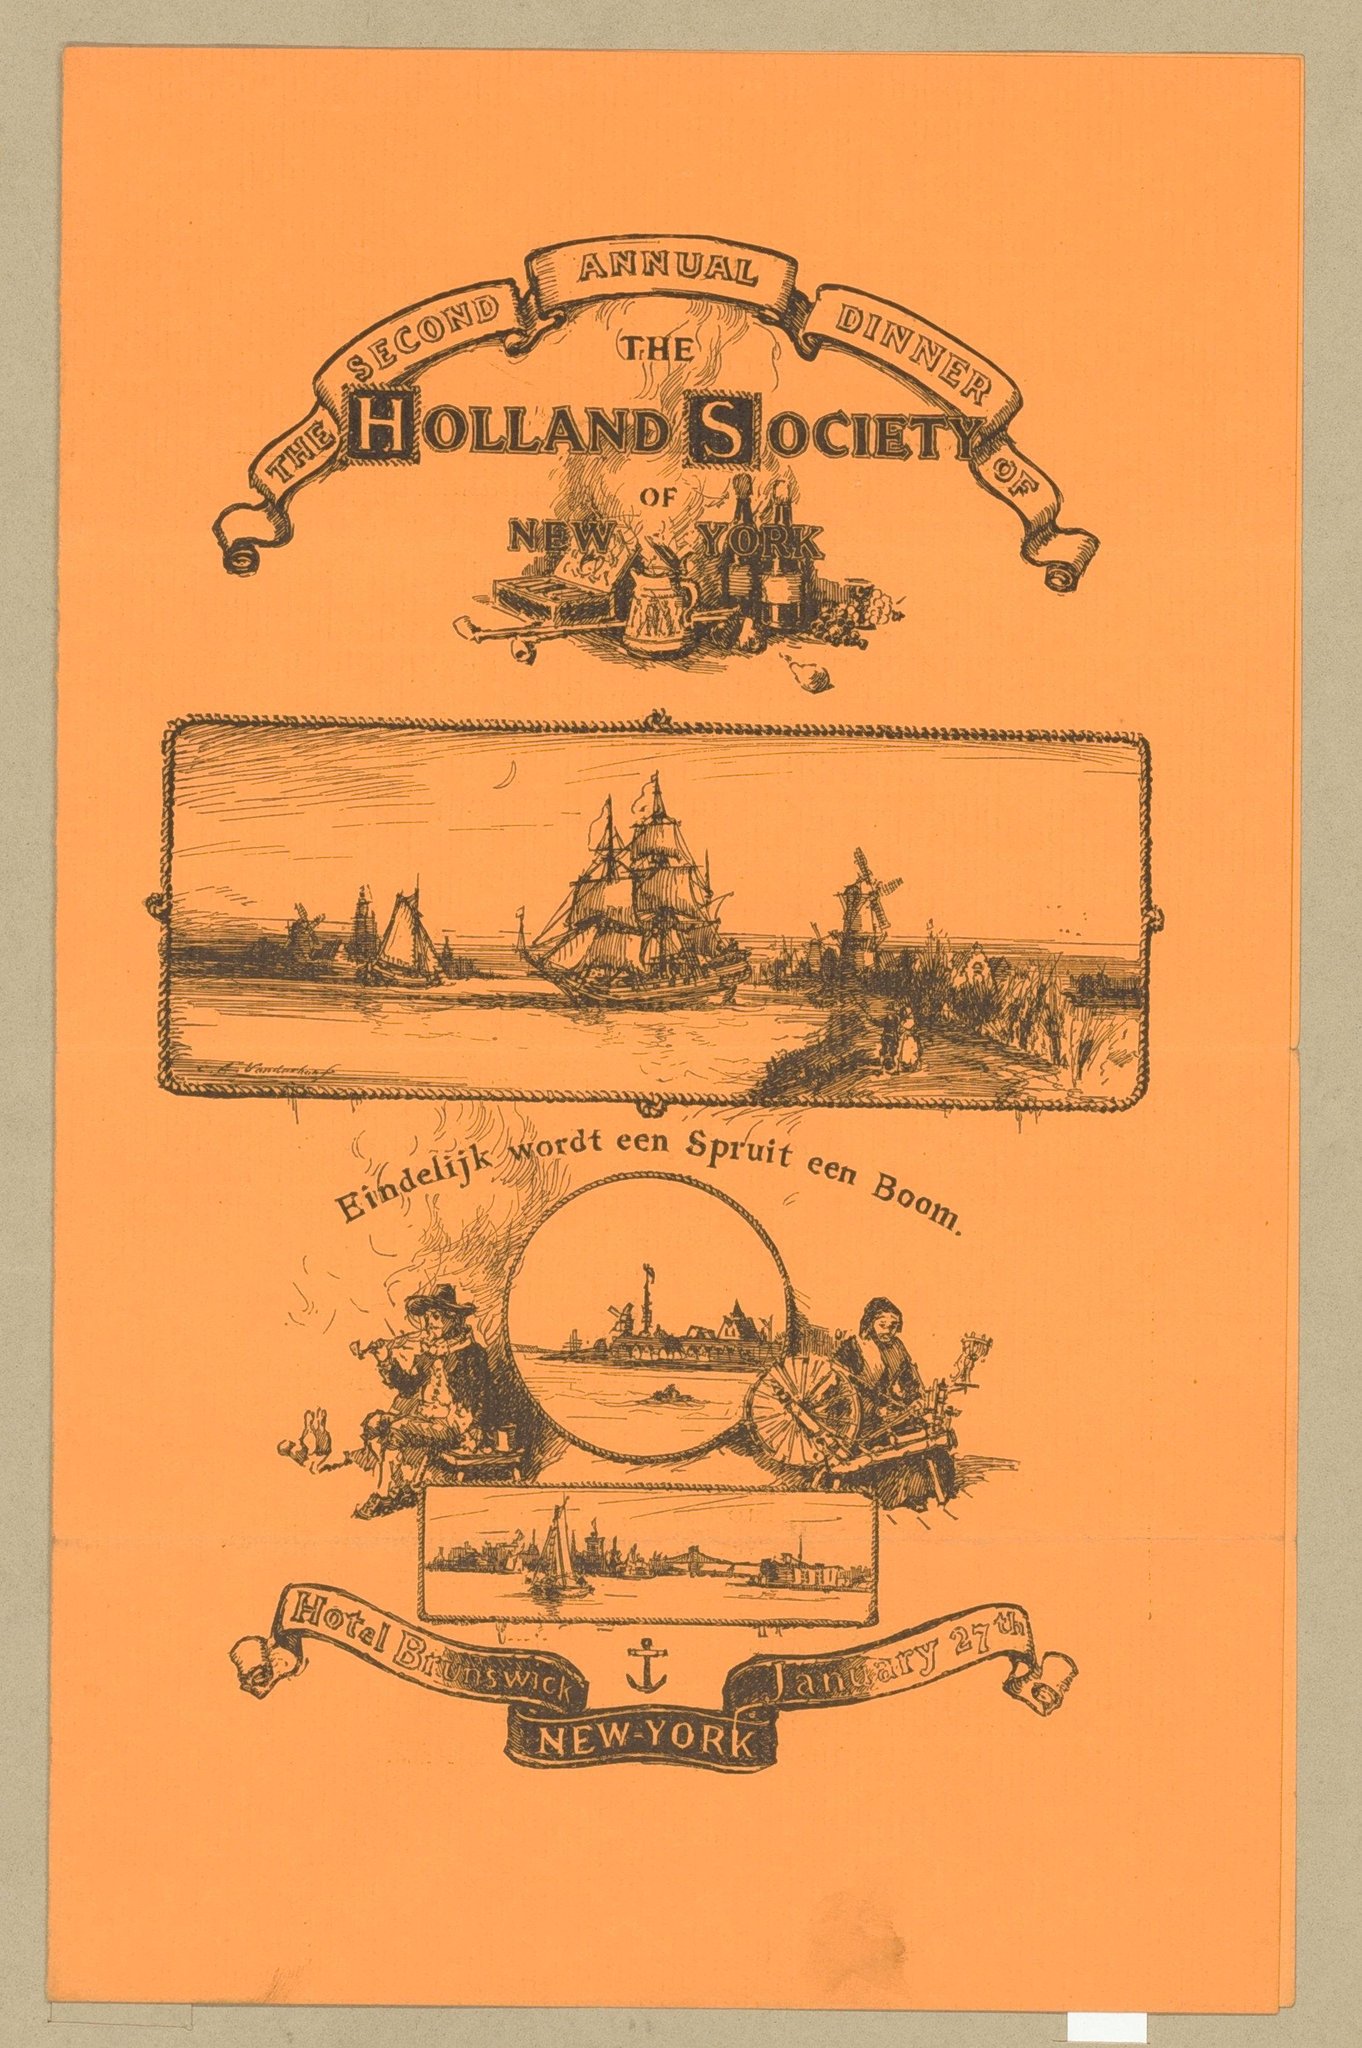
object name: menu, menukaart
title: Menukaart voor het twee jaarlijks diner van The Holland Society of New York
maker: Anonymous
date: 1887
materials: paper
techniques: letterpress printing, line block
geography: new york city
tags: harbour, sailing-ship, sailing-boat (+ view ~ vehicle, ship, etc.)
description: Menukaart voor het twee jaarlijks diner van The Holland Society of New York voor het jaar 1887. De menukaart bestaat als een gevouwen blad, die vier pagina's creëerd. Op de voorkant een schip in de haven, met daaronder een rokende man en een spinnende vrouw. Aan de binnenkant een menukaart en een lijst met heildronken. Op de achterkant de nammen van de leden van de Commissie tot regeling van den Maaltijd. Onderwerpsrubrieken binnen de Atlas Zeden en Gewoonten: Zeden en gewoonten in engeren zin, Volksleven, Uitspanningslokalen, Societeiten.